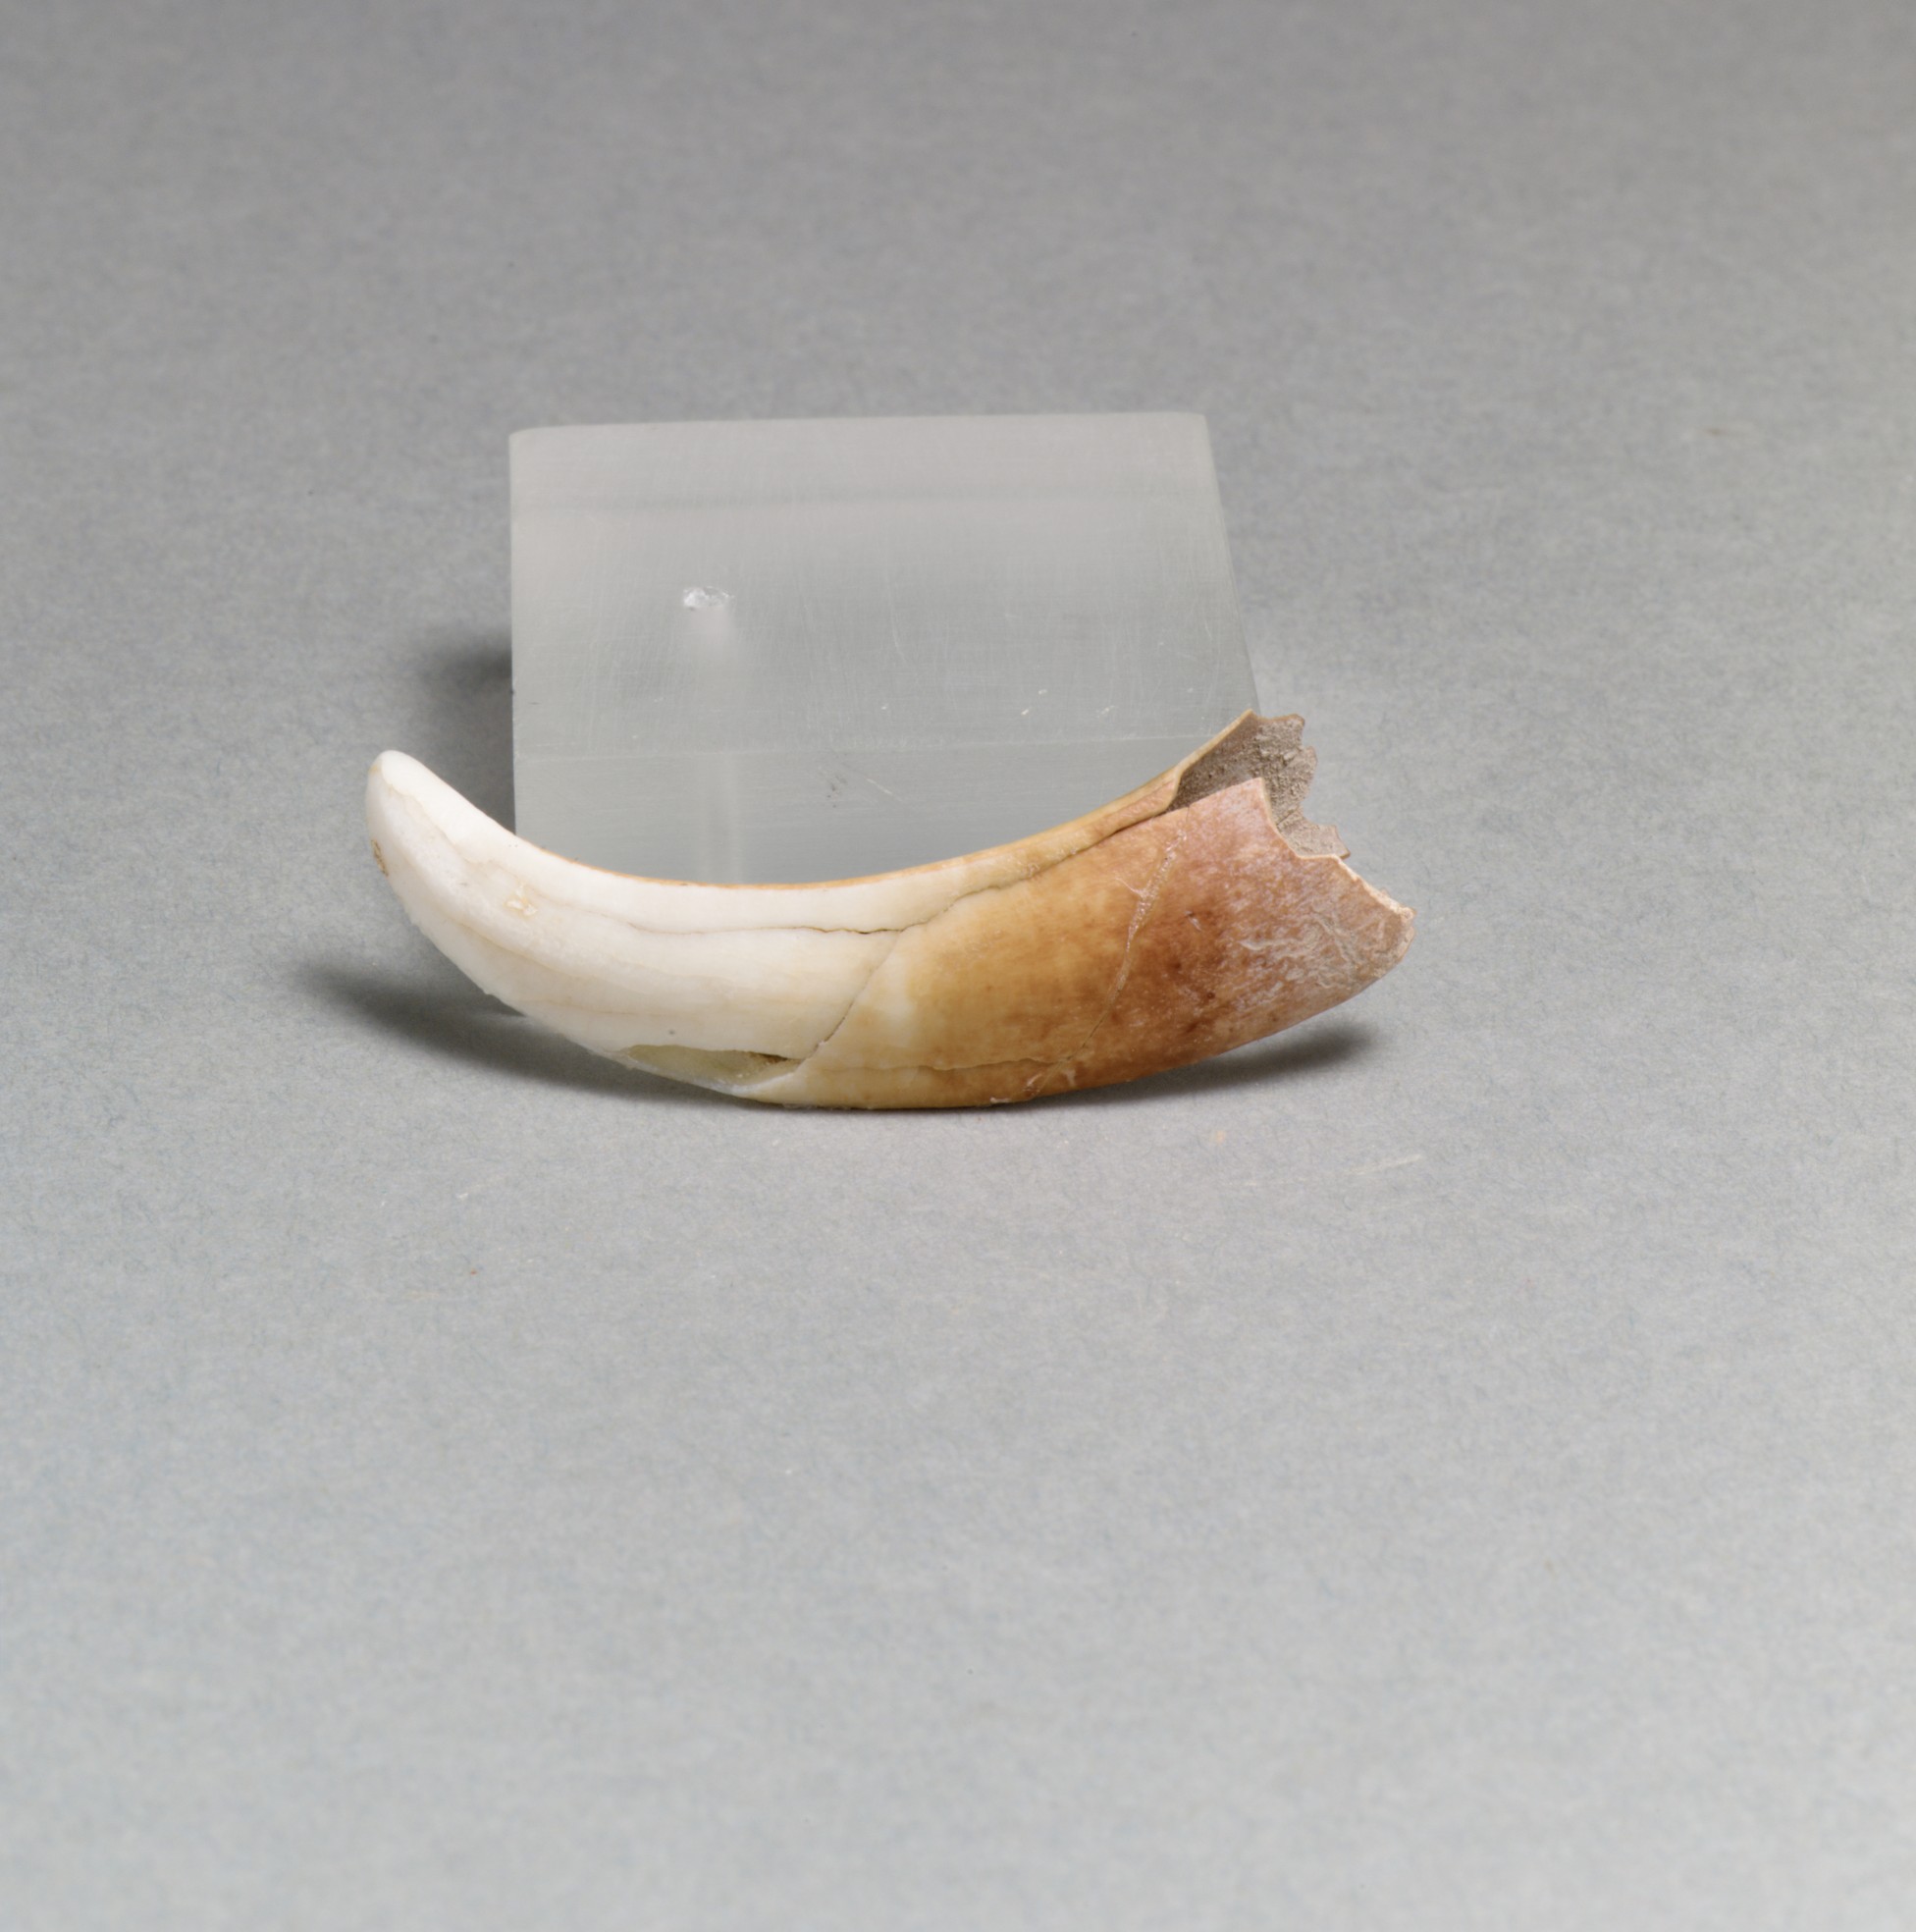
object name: tusk of boar, 2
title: Tusks of boar, 2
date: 7000 BCE-330 CE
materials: bone